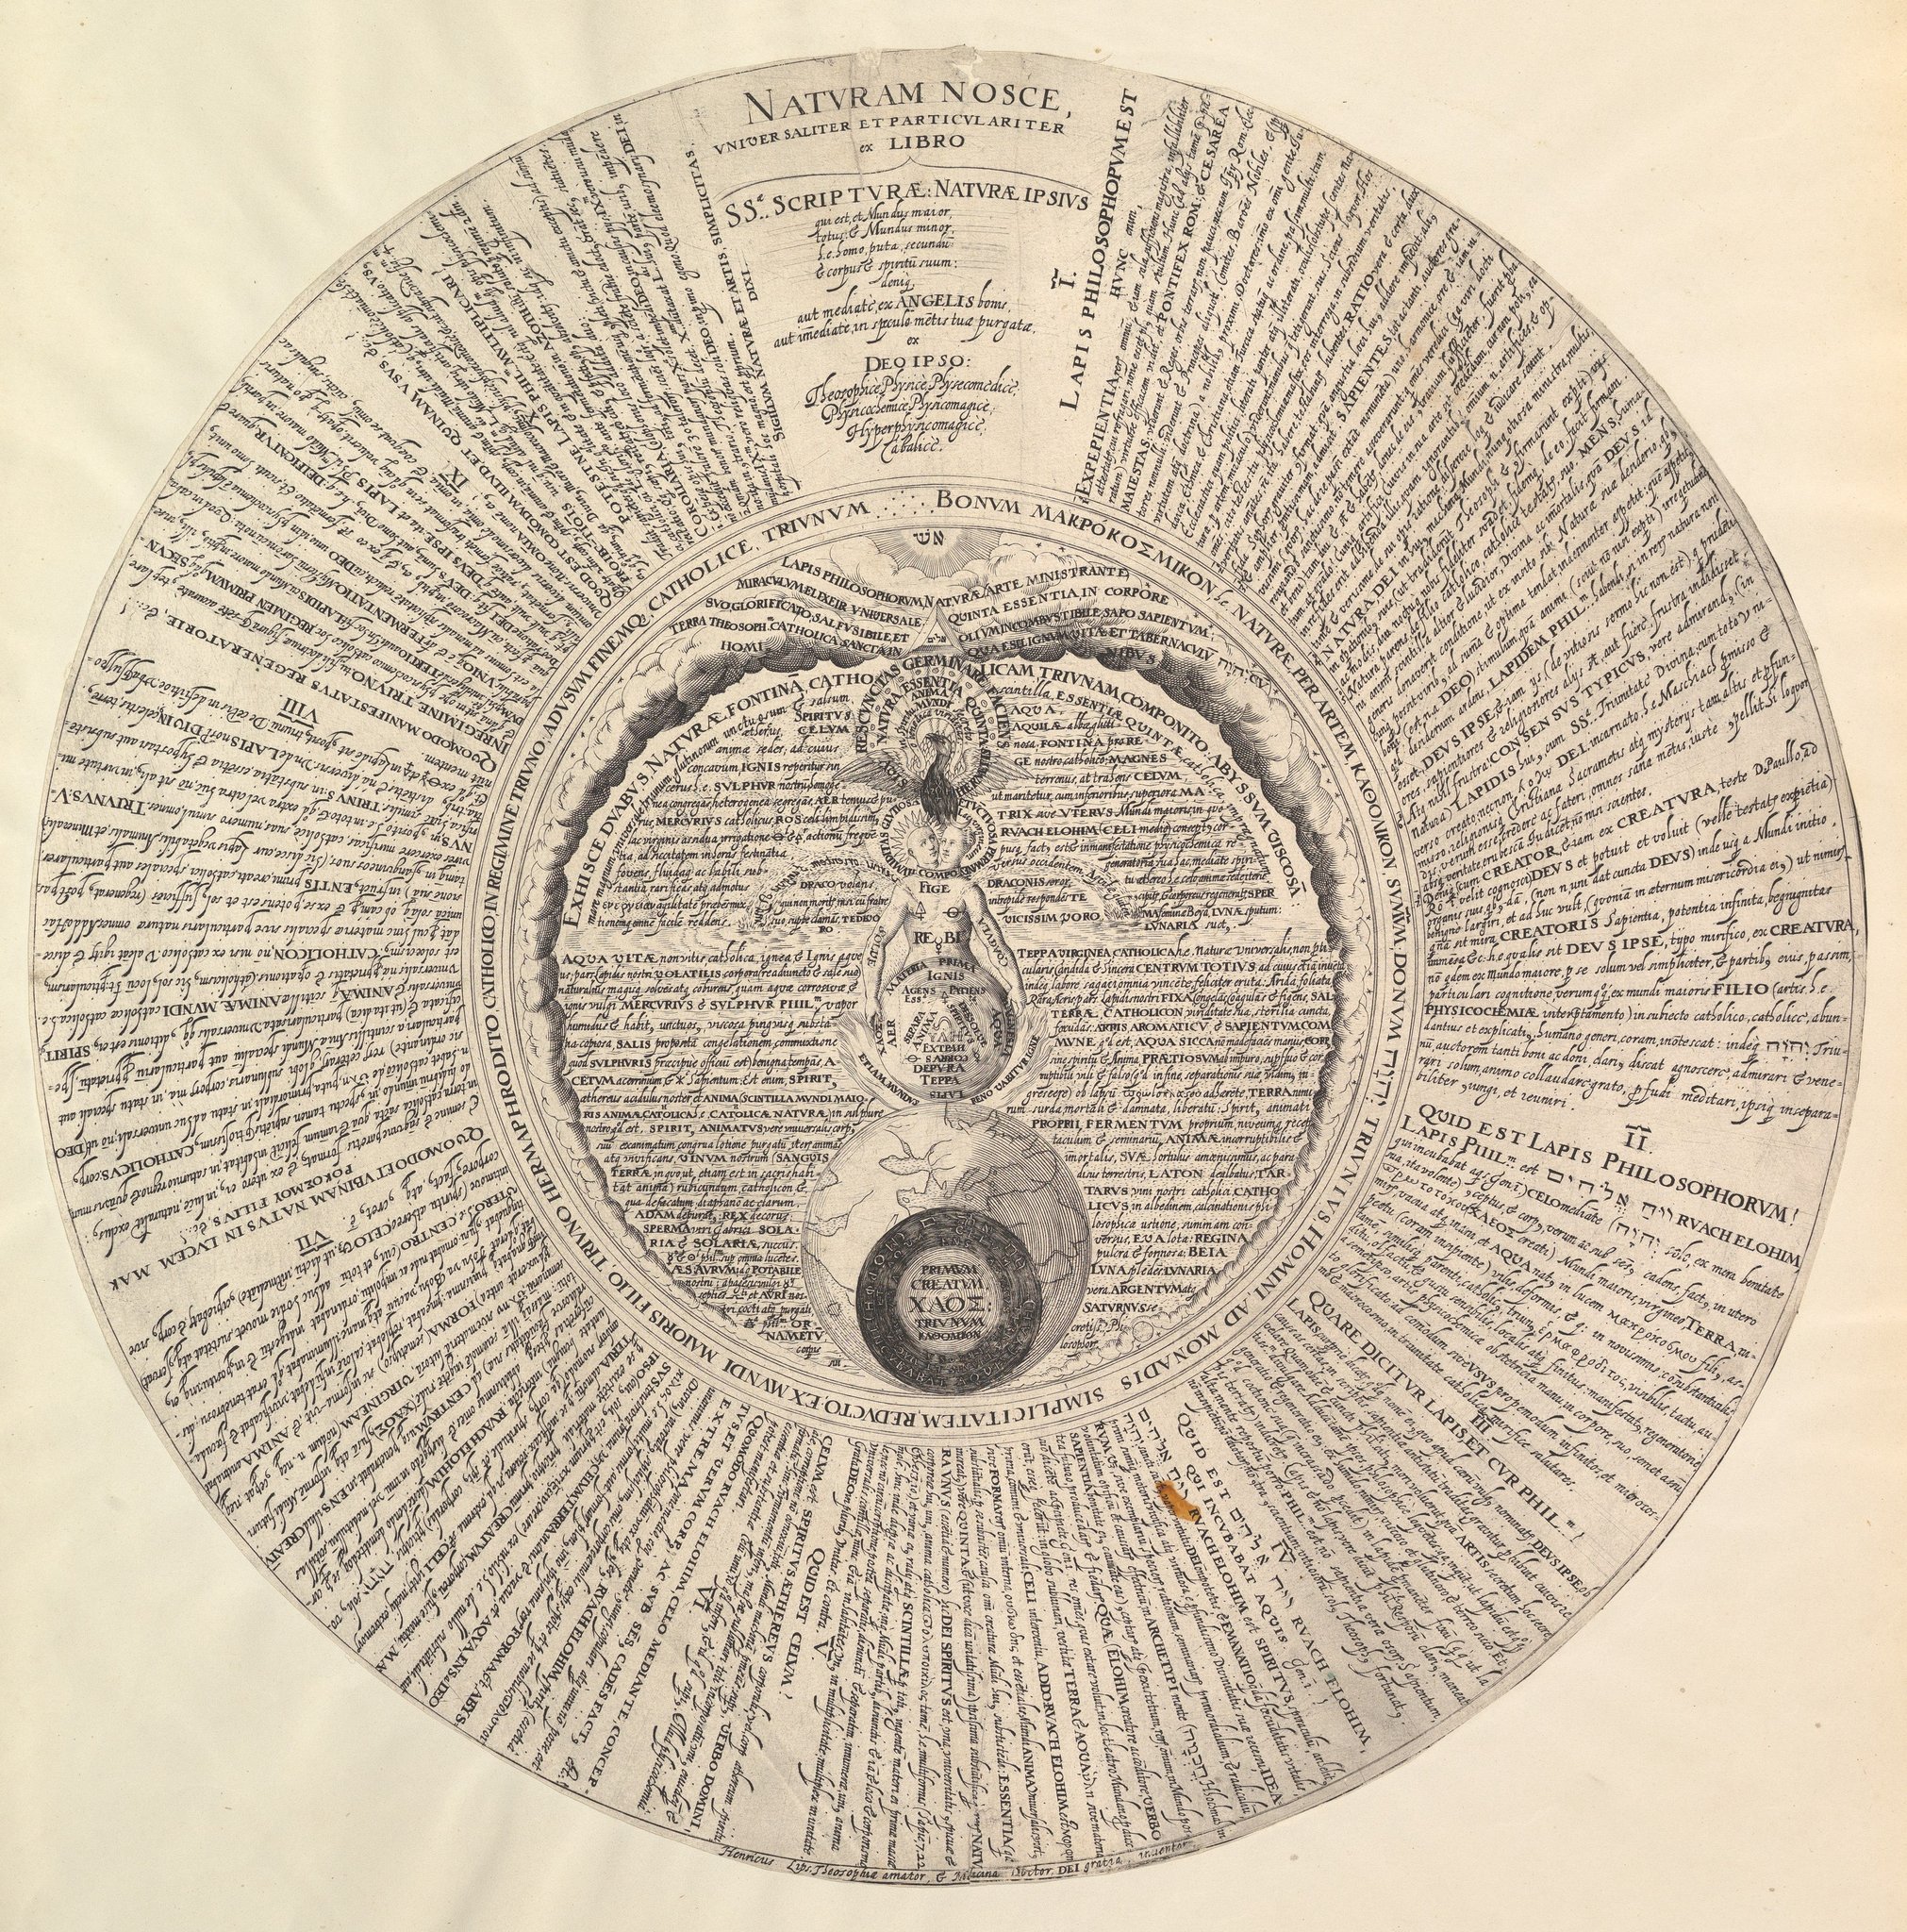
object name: print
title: The Philosopher's Stone from Heinrich Khunrath, Amphiteatrum sapientiae aeternae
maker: peter van der doort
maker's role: artist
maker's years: 1590-1605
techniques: engraving